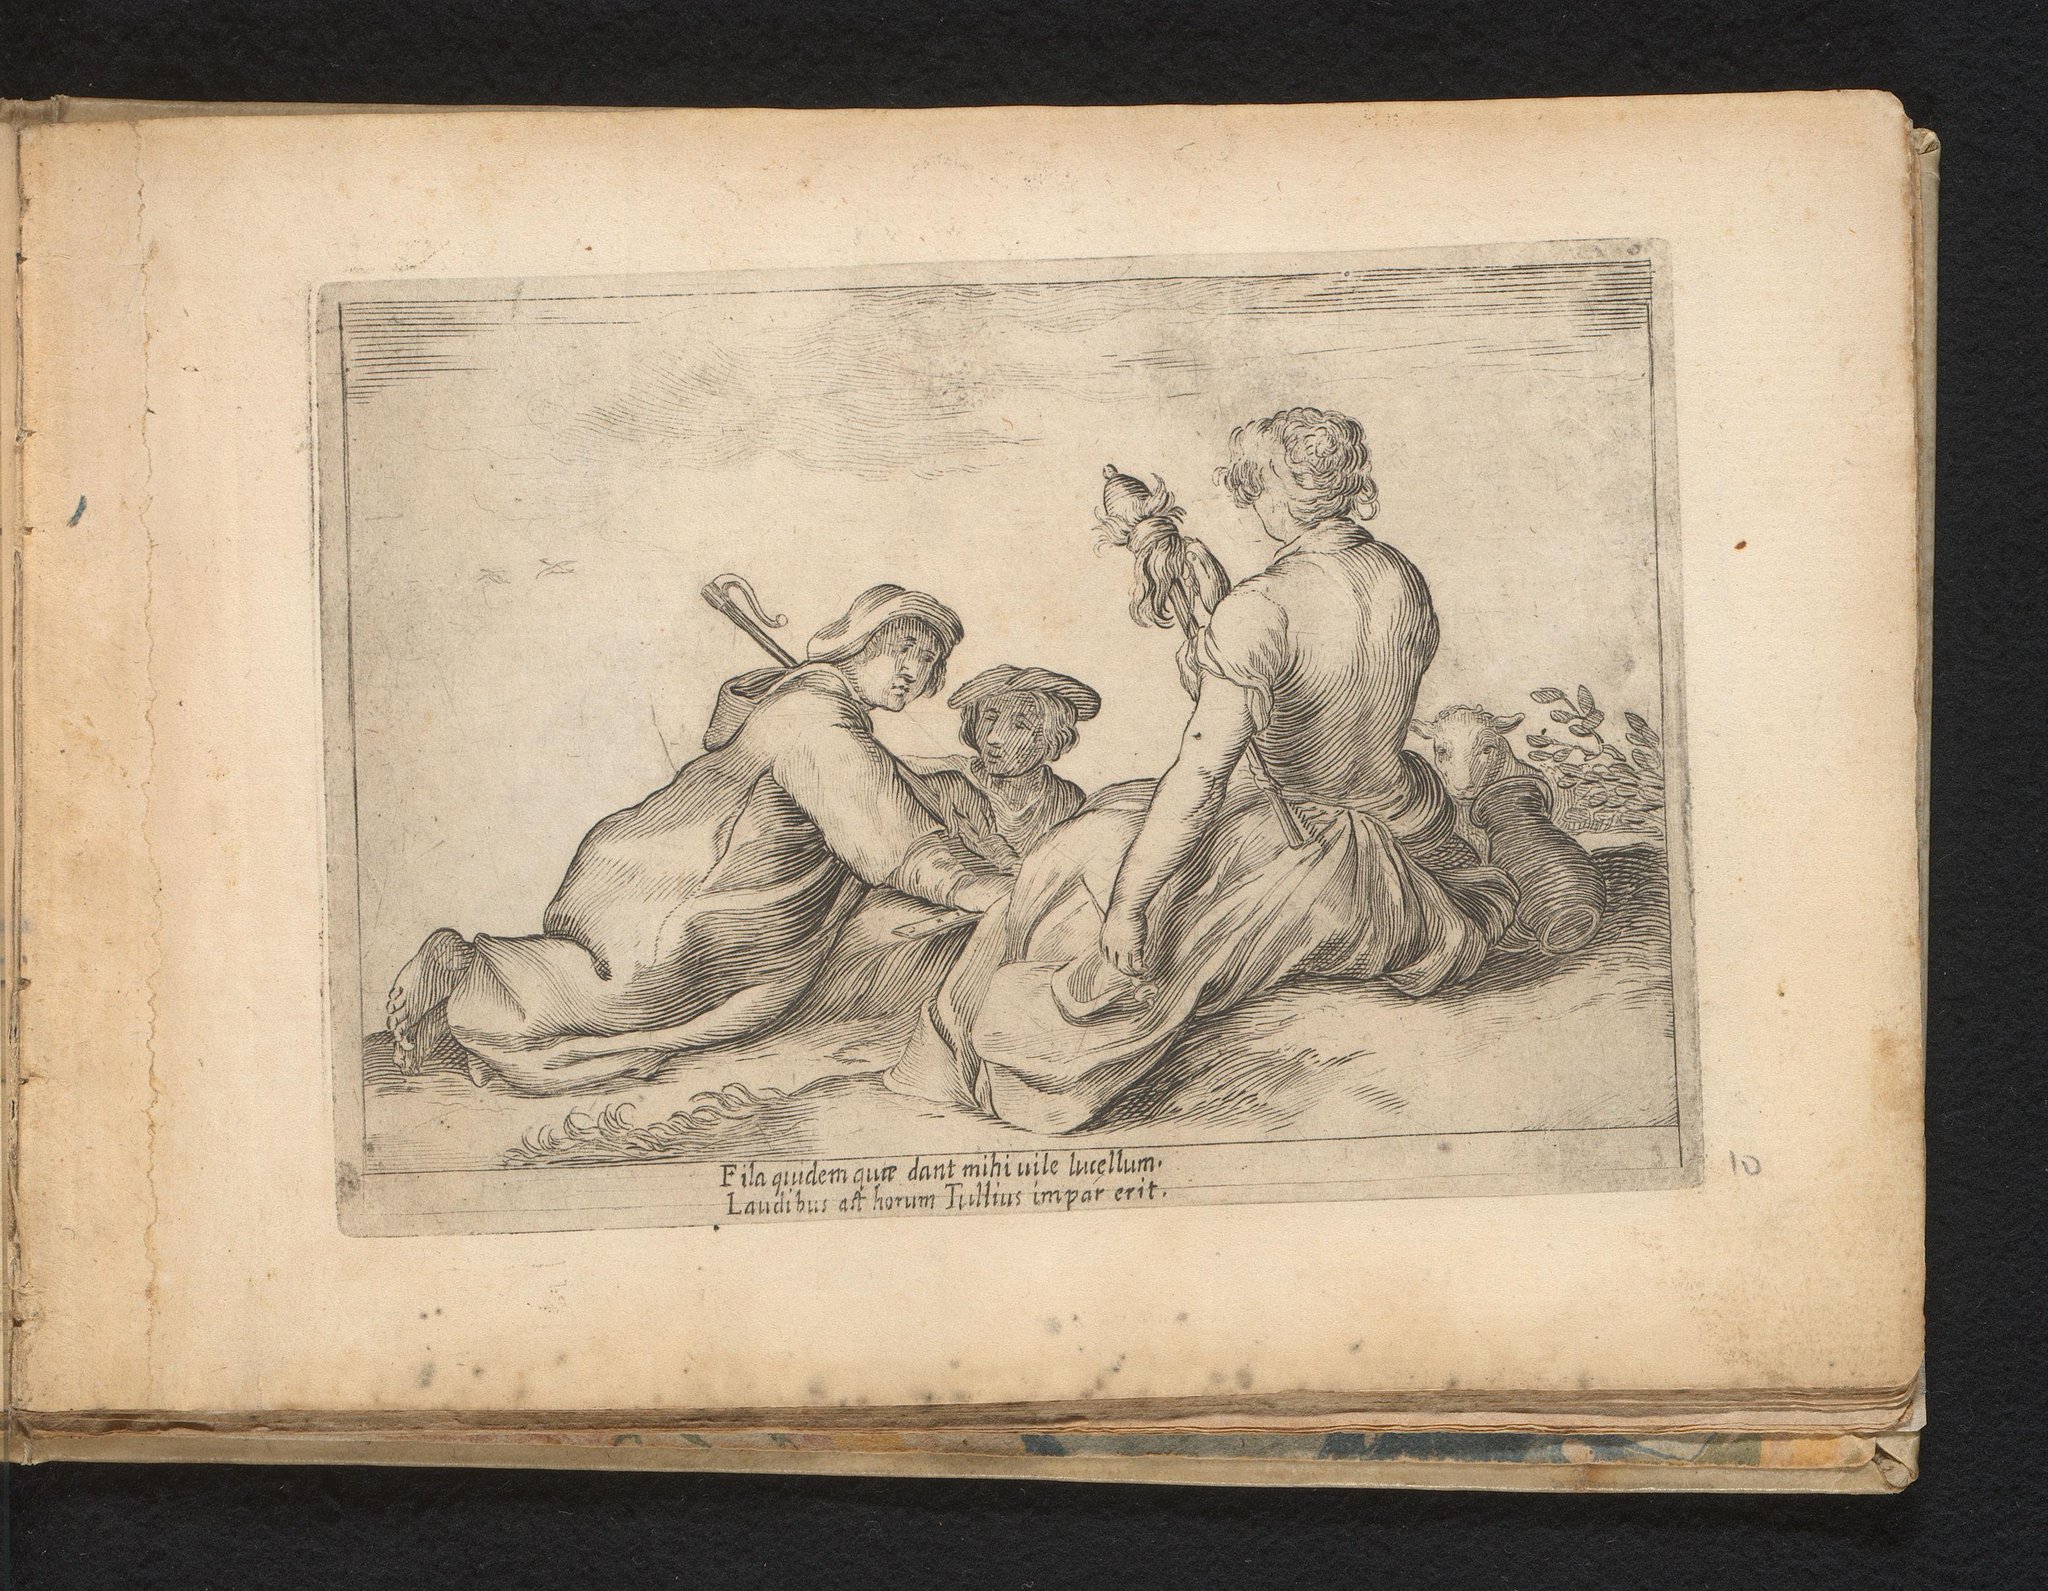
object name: print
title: Spinster met twee herdersjongens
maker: Anonymous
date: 1629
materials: ink, paper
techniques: engraving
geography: utrecht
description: Twee herders zitten met een vrouw op het gras. De vrouw houdt een stok omwonden met garen in haar hand. Met tweeregelig vers in het Latijn in ondermarge. Het betreft de serie getiteld: Otia delectant faciuntq [...]. Kalfsleren band met opschrift en decoratieve kaderlijnen in pen in bruin. Voorin en achterin vier schutbladen van velijn.